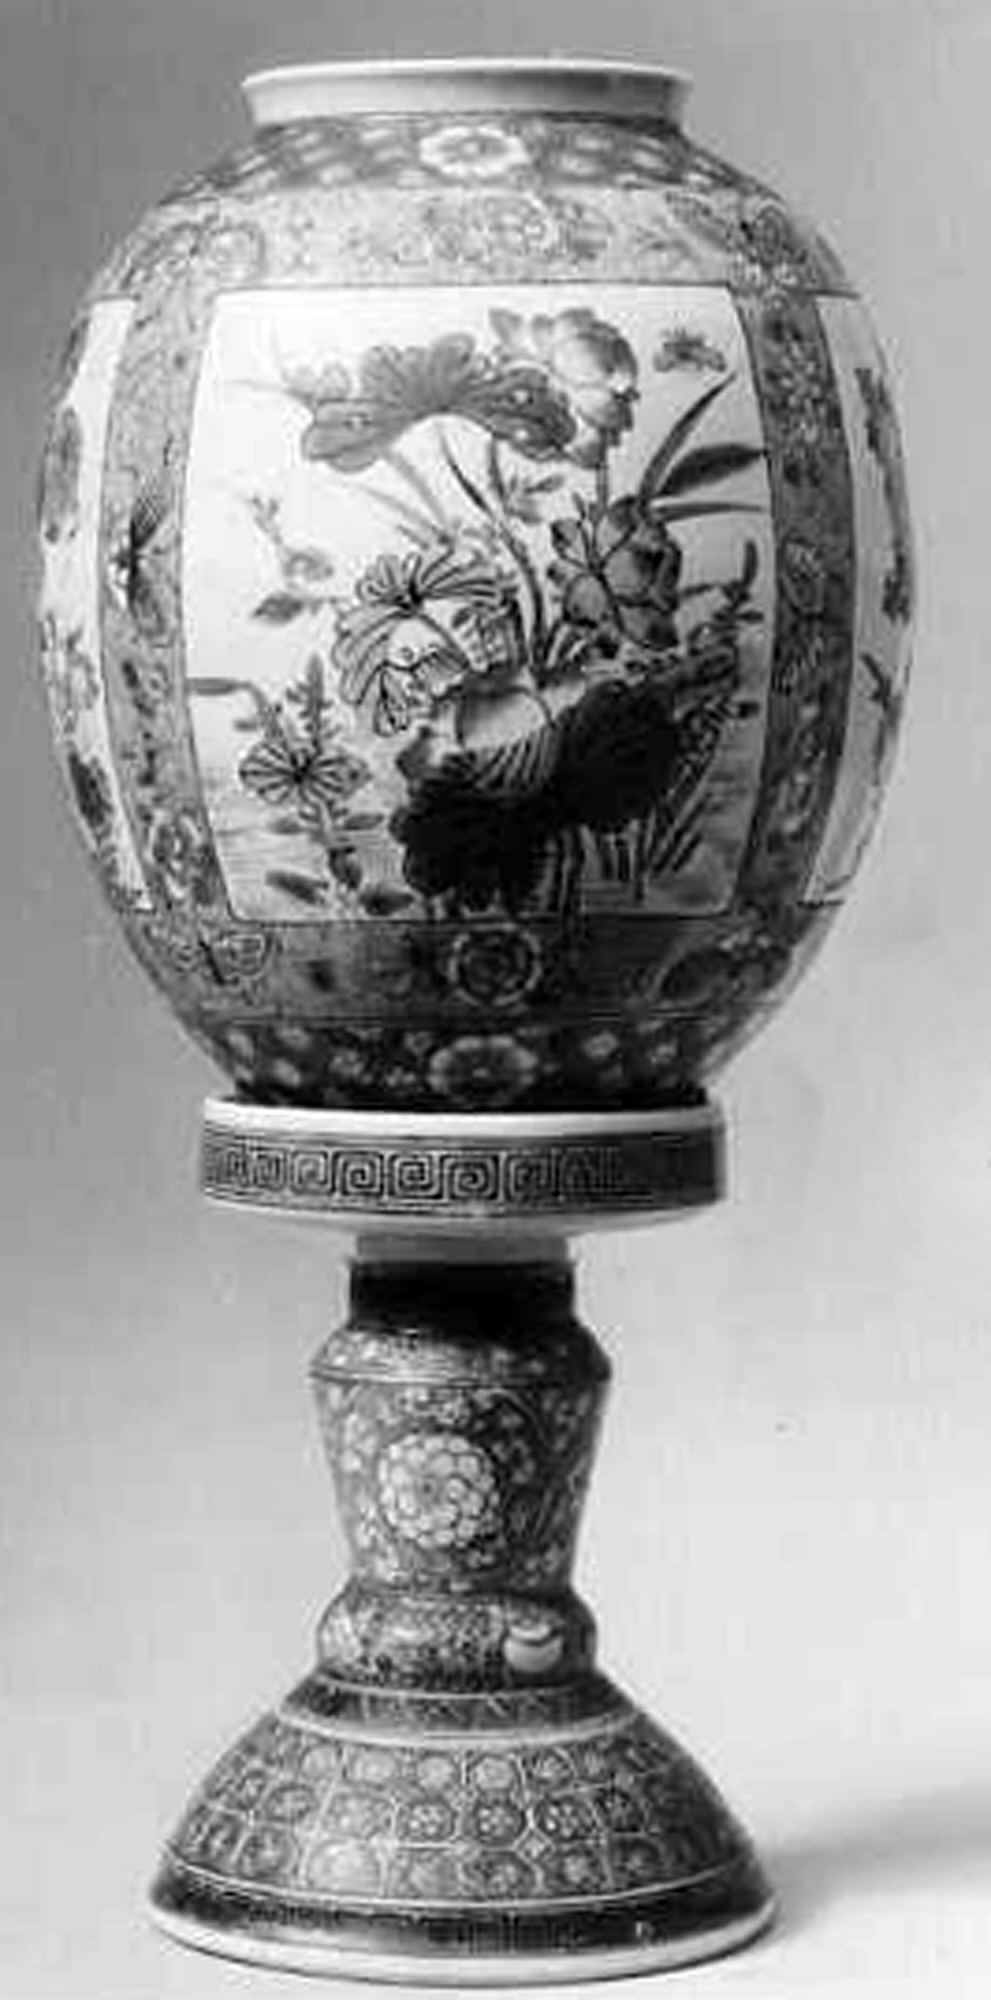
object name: lantern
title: Lantern (one of a pair)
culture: chinese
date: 1723-1735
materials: enamel, porcelain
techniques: painting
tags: flowers